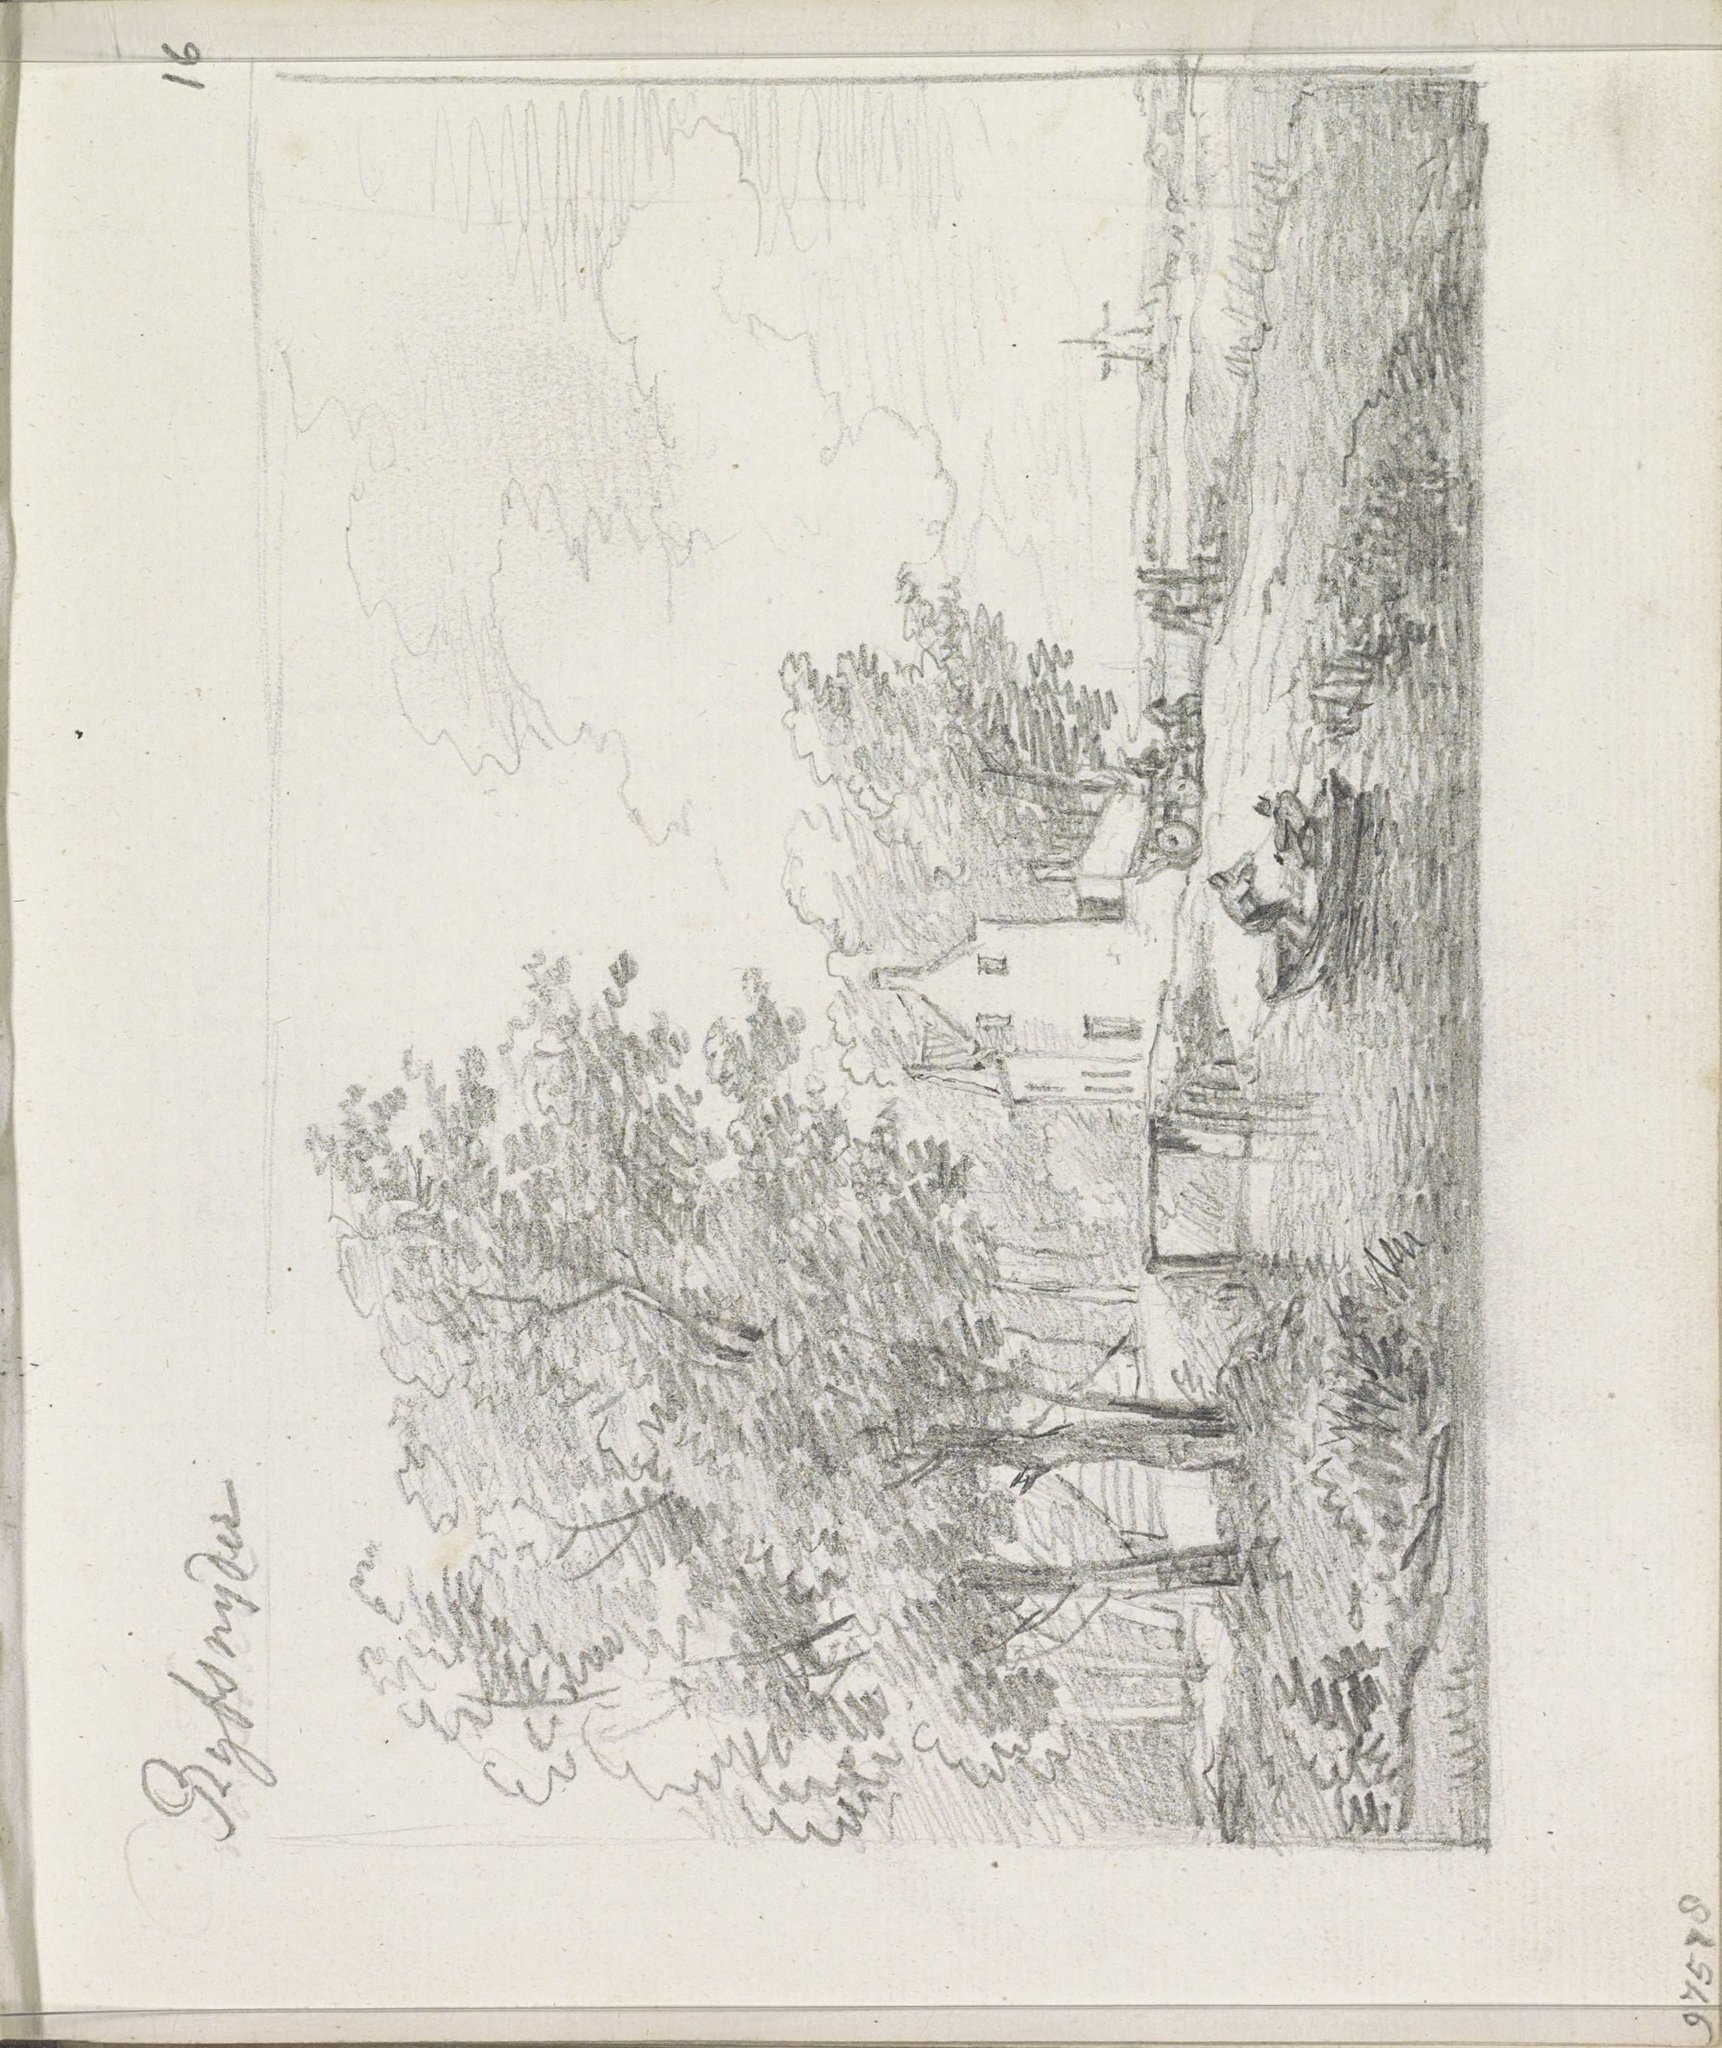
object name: sketchbook leaf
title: Landschap met figuren in een roeiboot bij een brug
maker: andreas schelfhout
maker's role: draughtsman, painter, print maker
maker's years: 1787-1870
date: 1825-1829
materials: paper, pencil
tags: bridge, landscapes with waters, waterscapes, seascapes (in the temperate zone) (+ landscape with figures, staffage)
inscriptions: number: ‘16/ 97571’, annotation: ‘Rijfsnijder’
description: Op de achtergrond een molen. Blad 30 recto uit een schetsboek met 95 bladen.